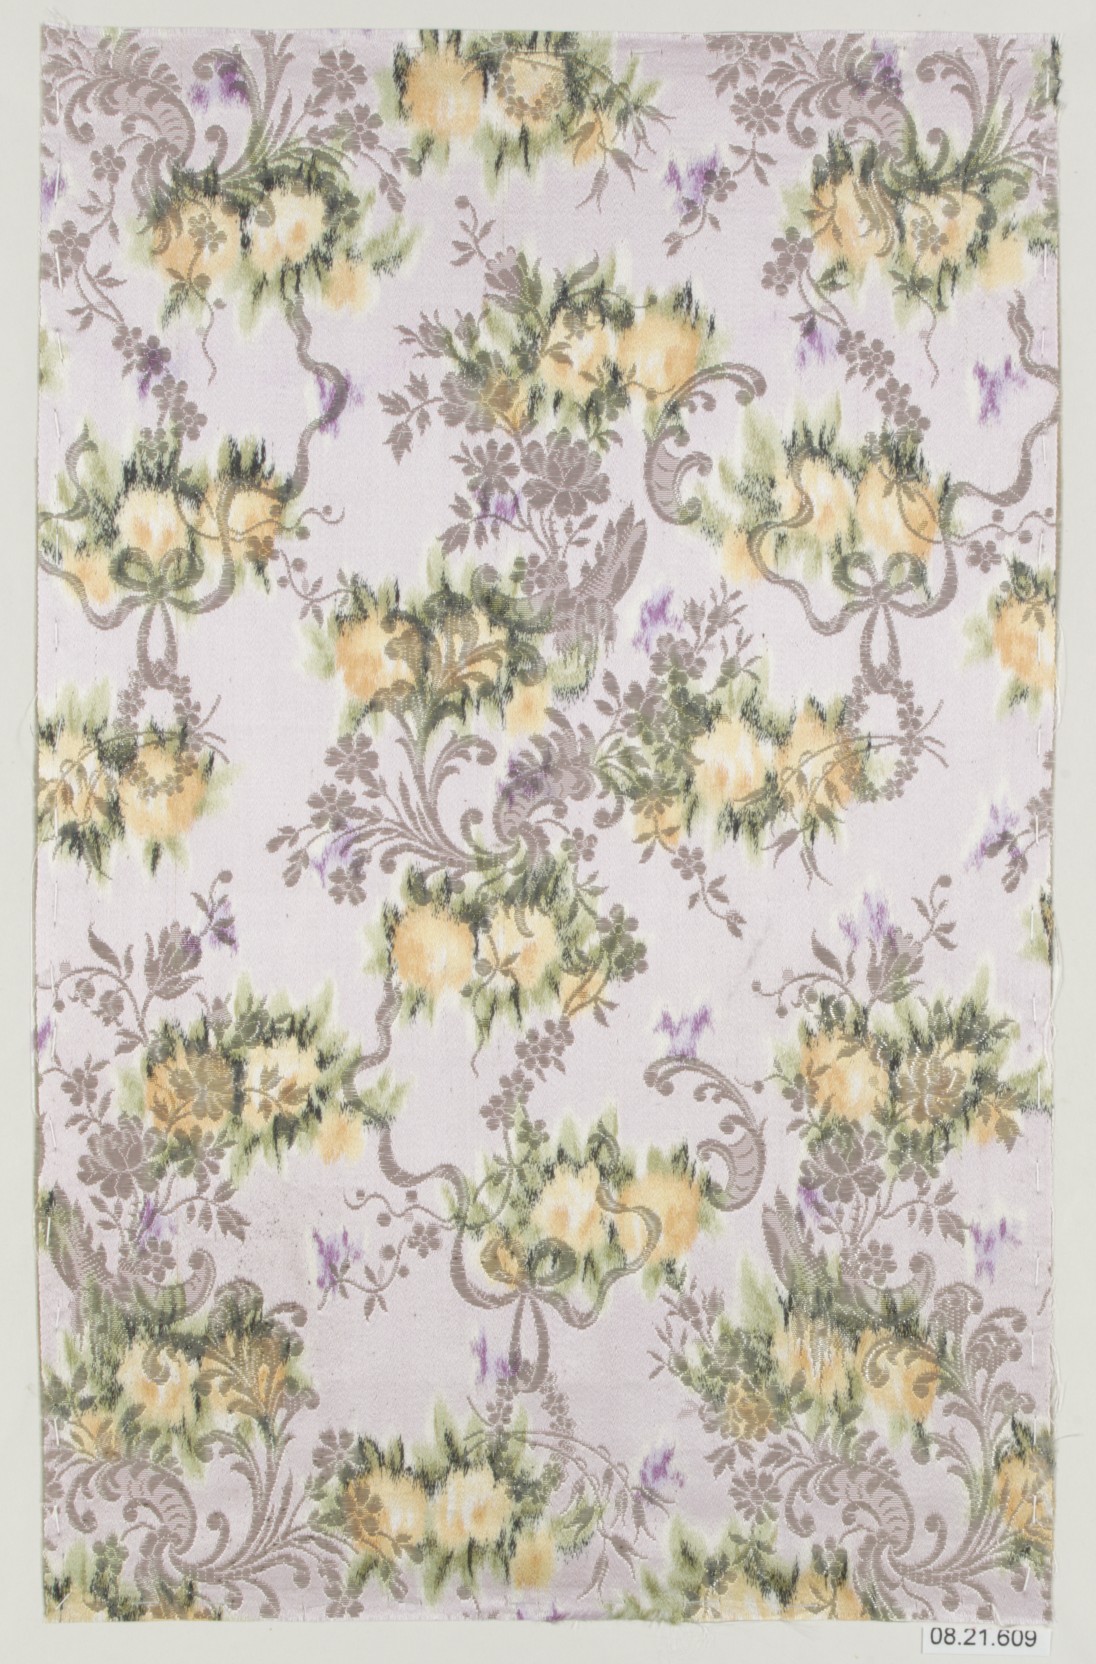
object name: textile sample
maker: Anonymous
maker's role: designer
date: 1900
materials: silk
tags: flowers